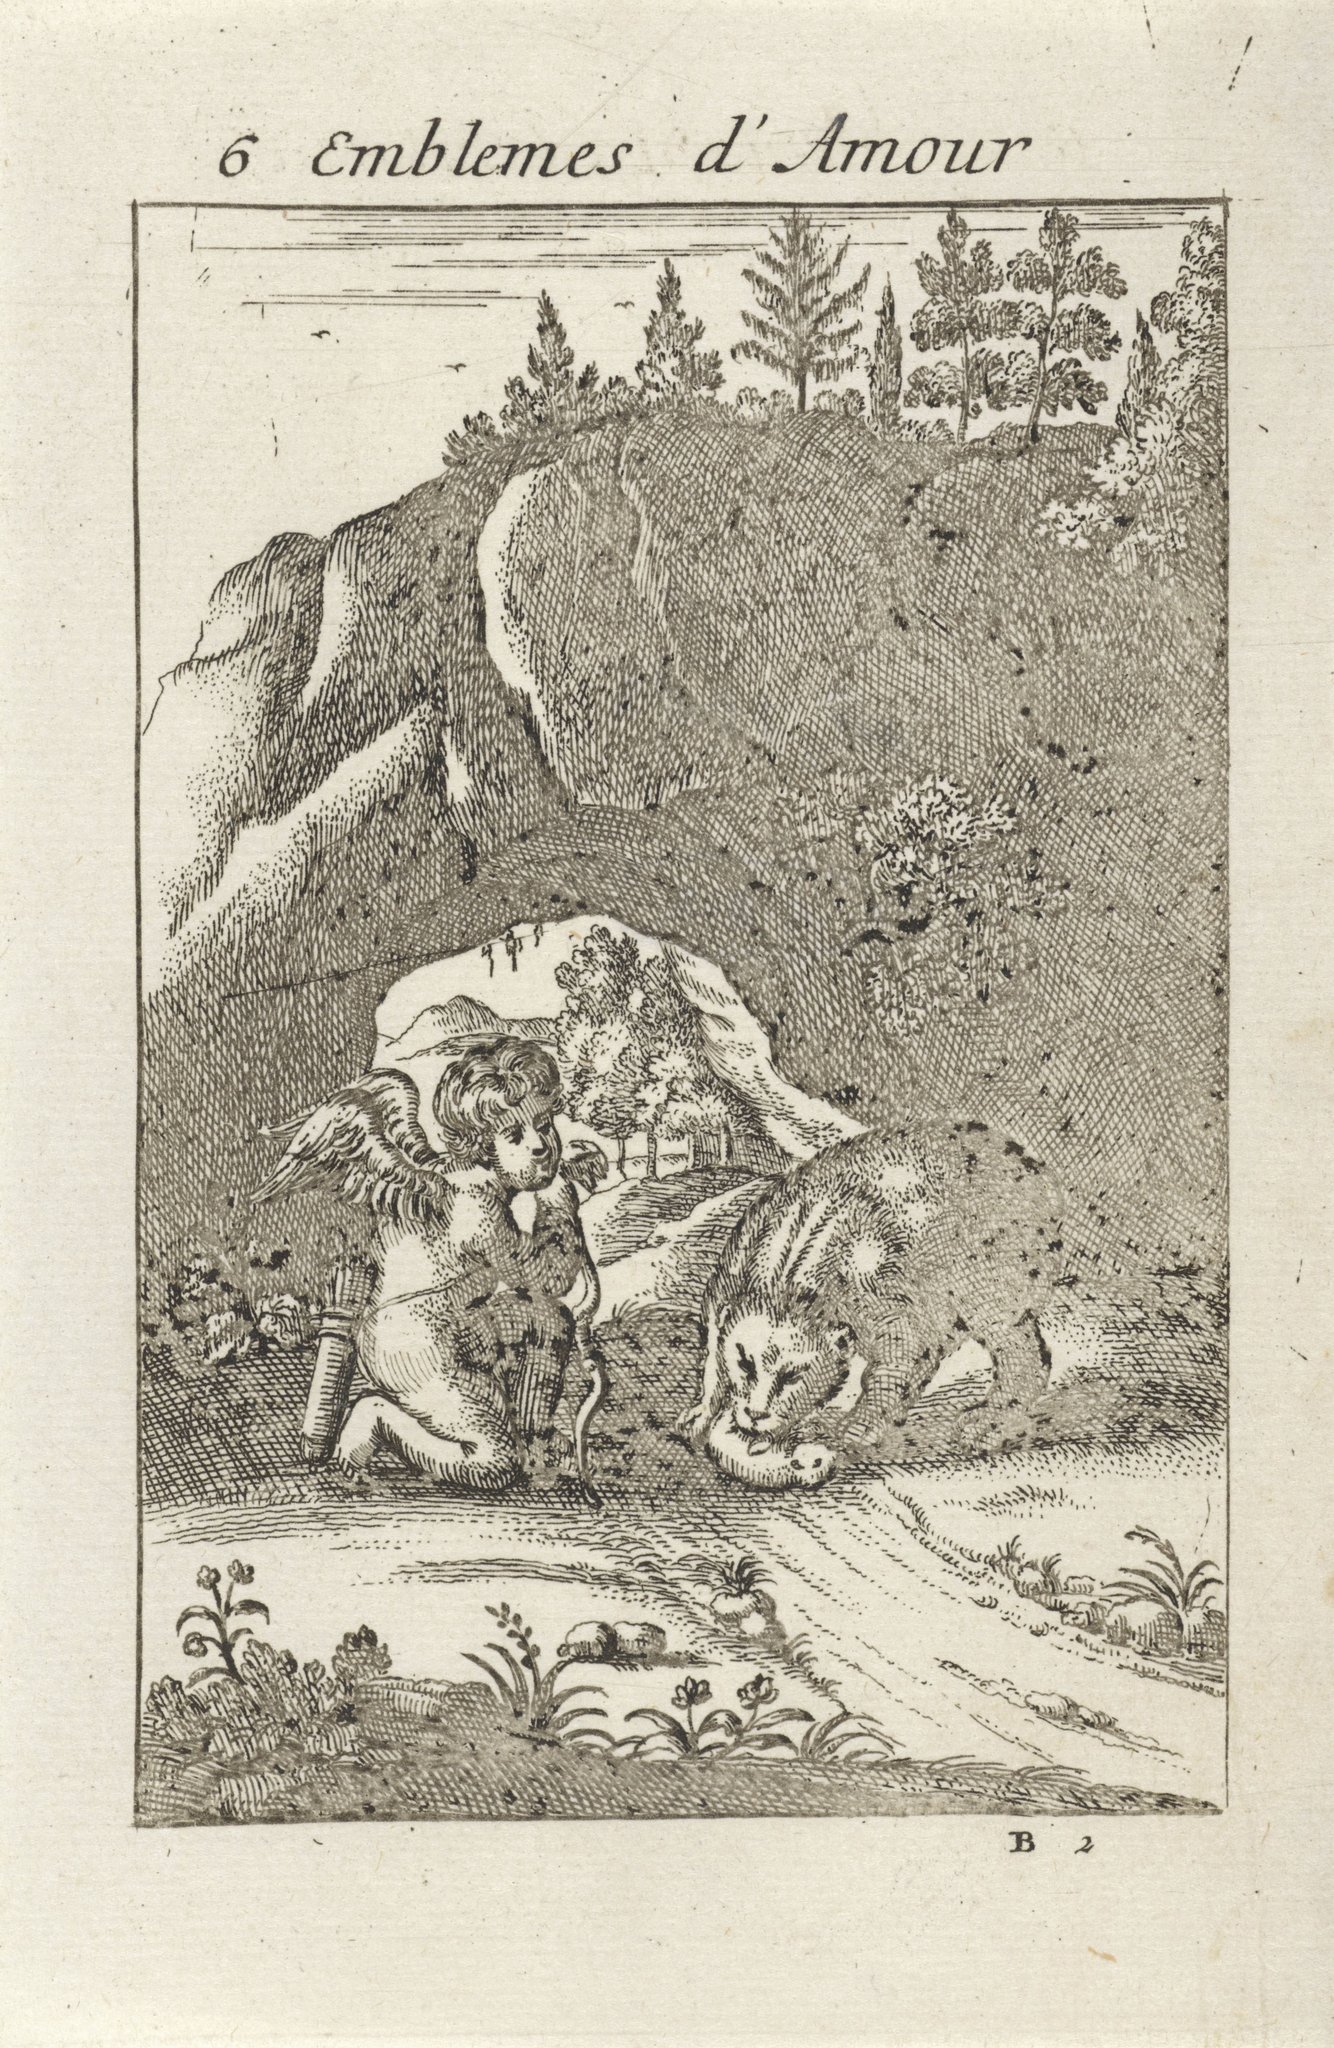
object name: book illustration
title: Amor bij een beer die haar jong likt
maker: jan van vianen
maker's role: print maker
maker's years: 1660-1726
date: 1686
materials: paper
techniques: etching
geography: northern netherlands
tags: (story of) cupid, amor (eros), beasts of prey, predatory animals: bear (+ animals used symbolically)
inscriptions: collector's mark: Lugt 2228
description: Amor knielt neer bij een beer die haar jong likt. Net zoals de beer haar jongt likt terwijl die opgroeit, zo zullen geliefden zich naar elkaar schikken door met elkaar te vrijen. Zesde embleem uit Emblemata Amatoria.